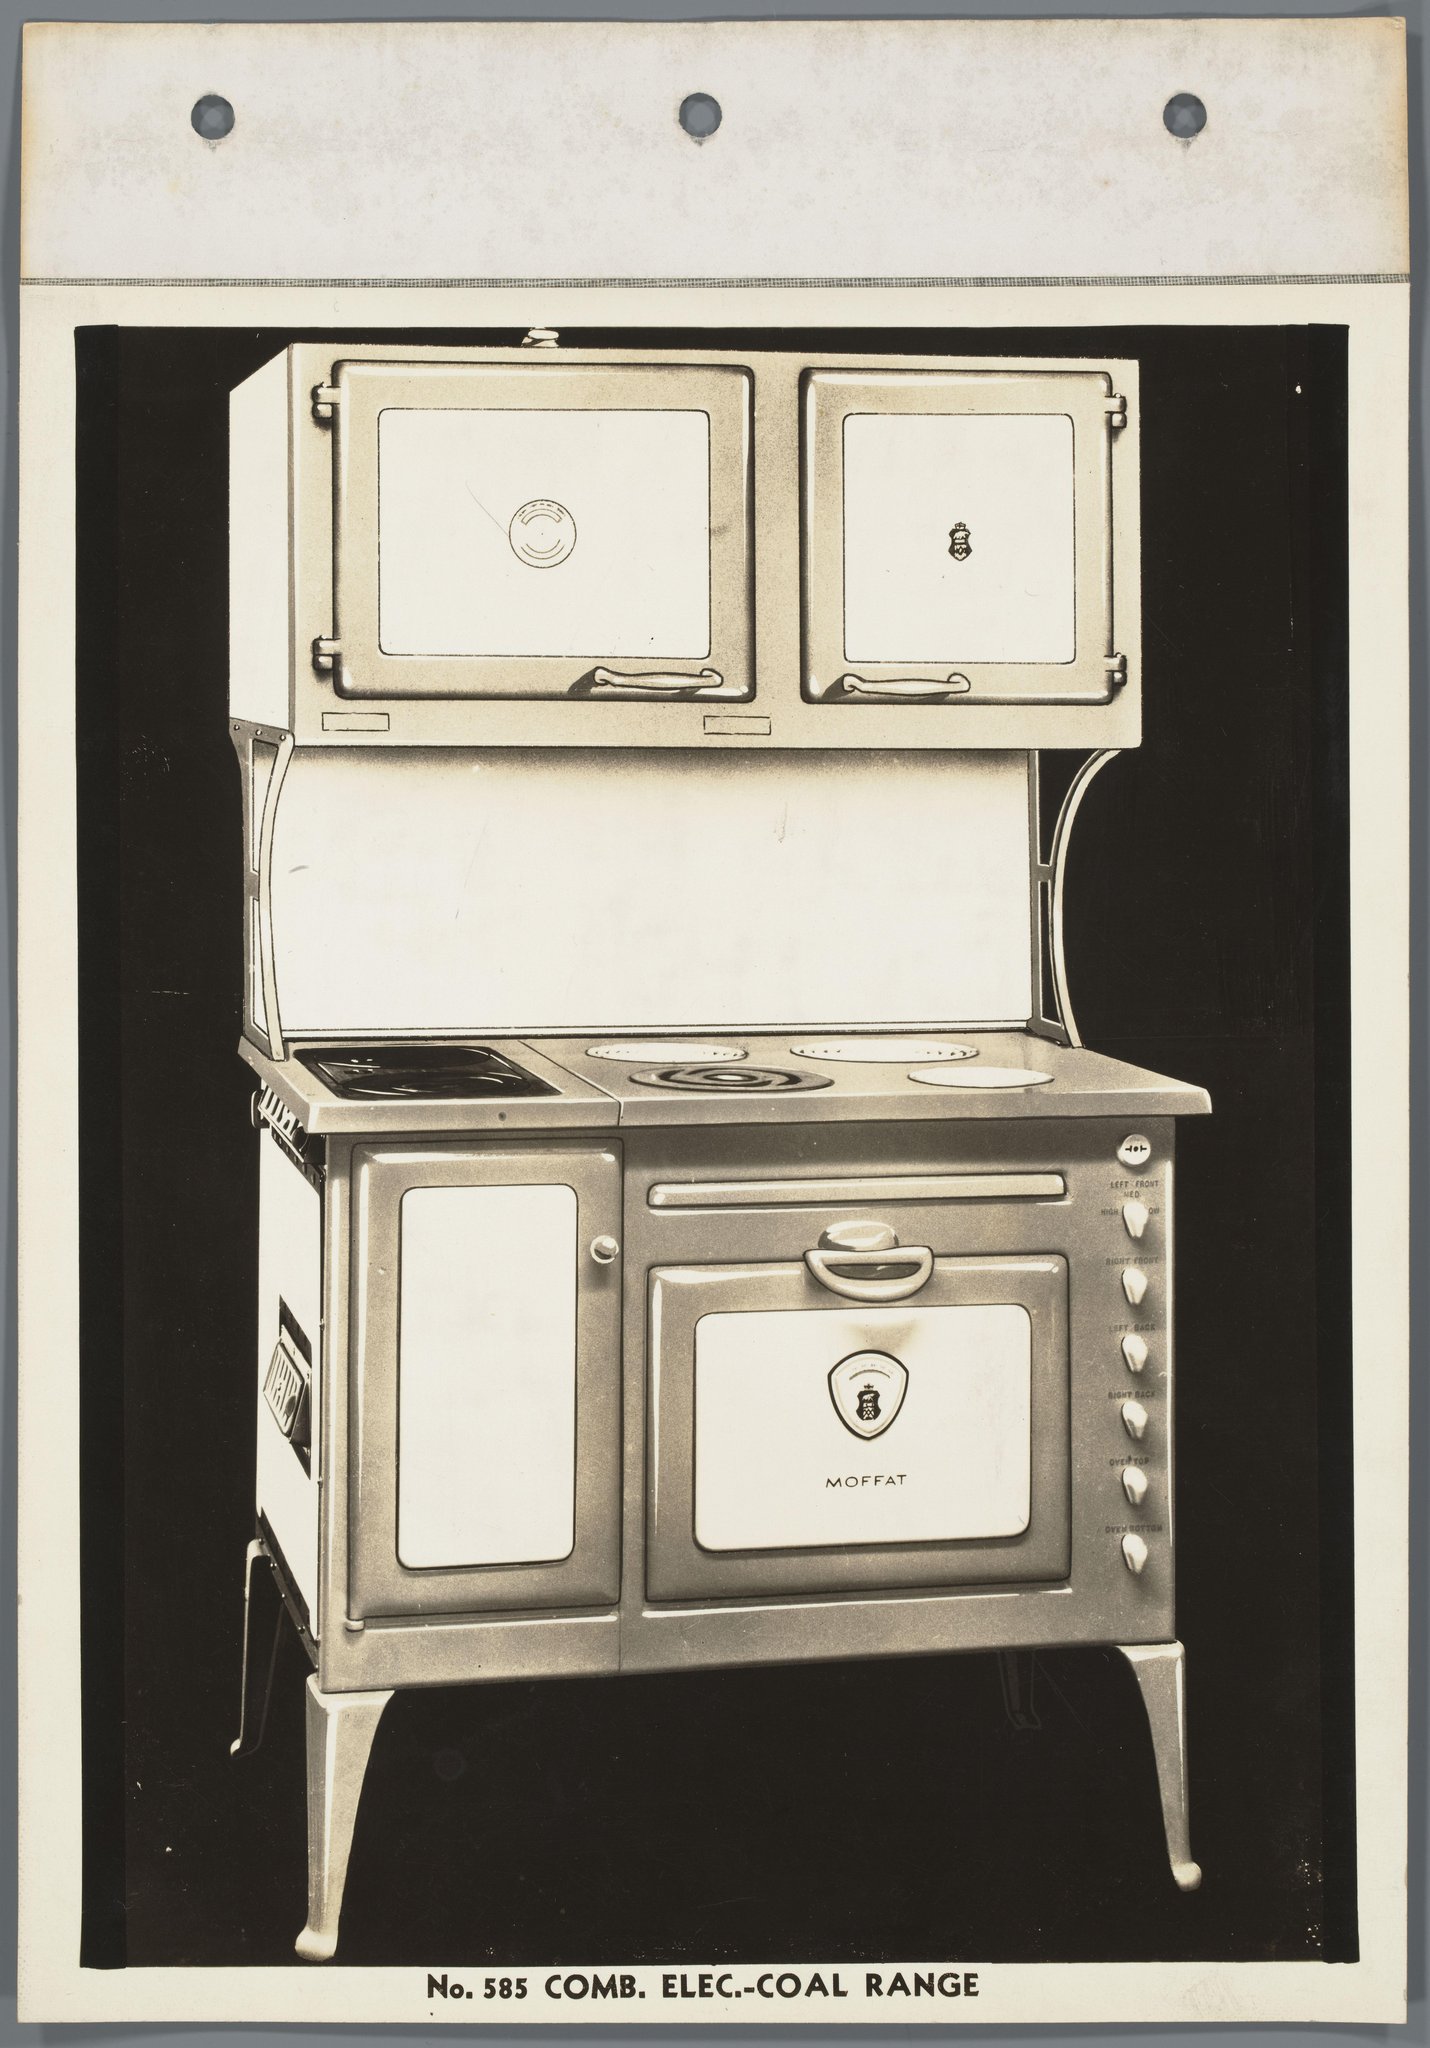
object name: photograph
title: Foto van Moffat ovens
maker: Anonymous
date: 1935-1940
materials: paper, photographic support, textile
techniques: gelatin silver print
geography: canada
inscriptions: inscription: ‘No. 585 COMB. ELEC.-COAL RANGE’